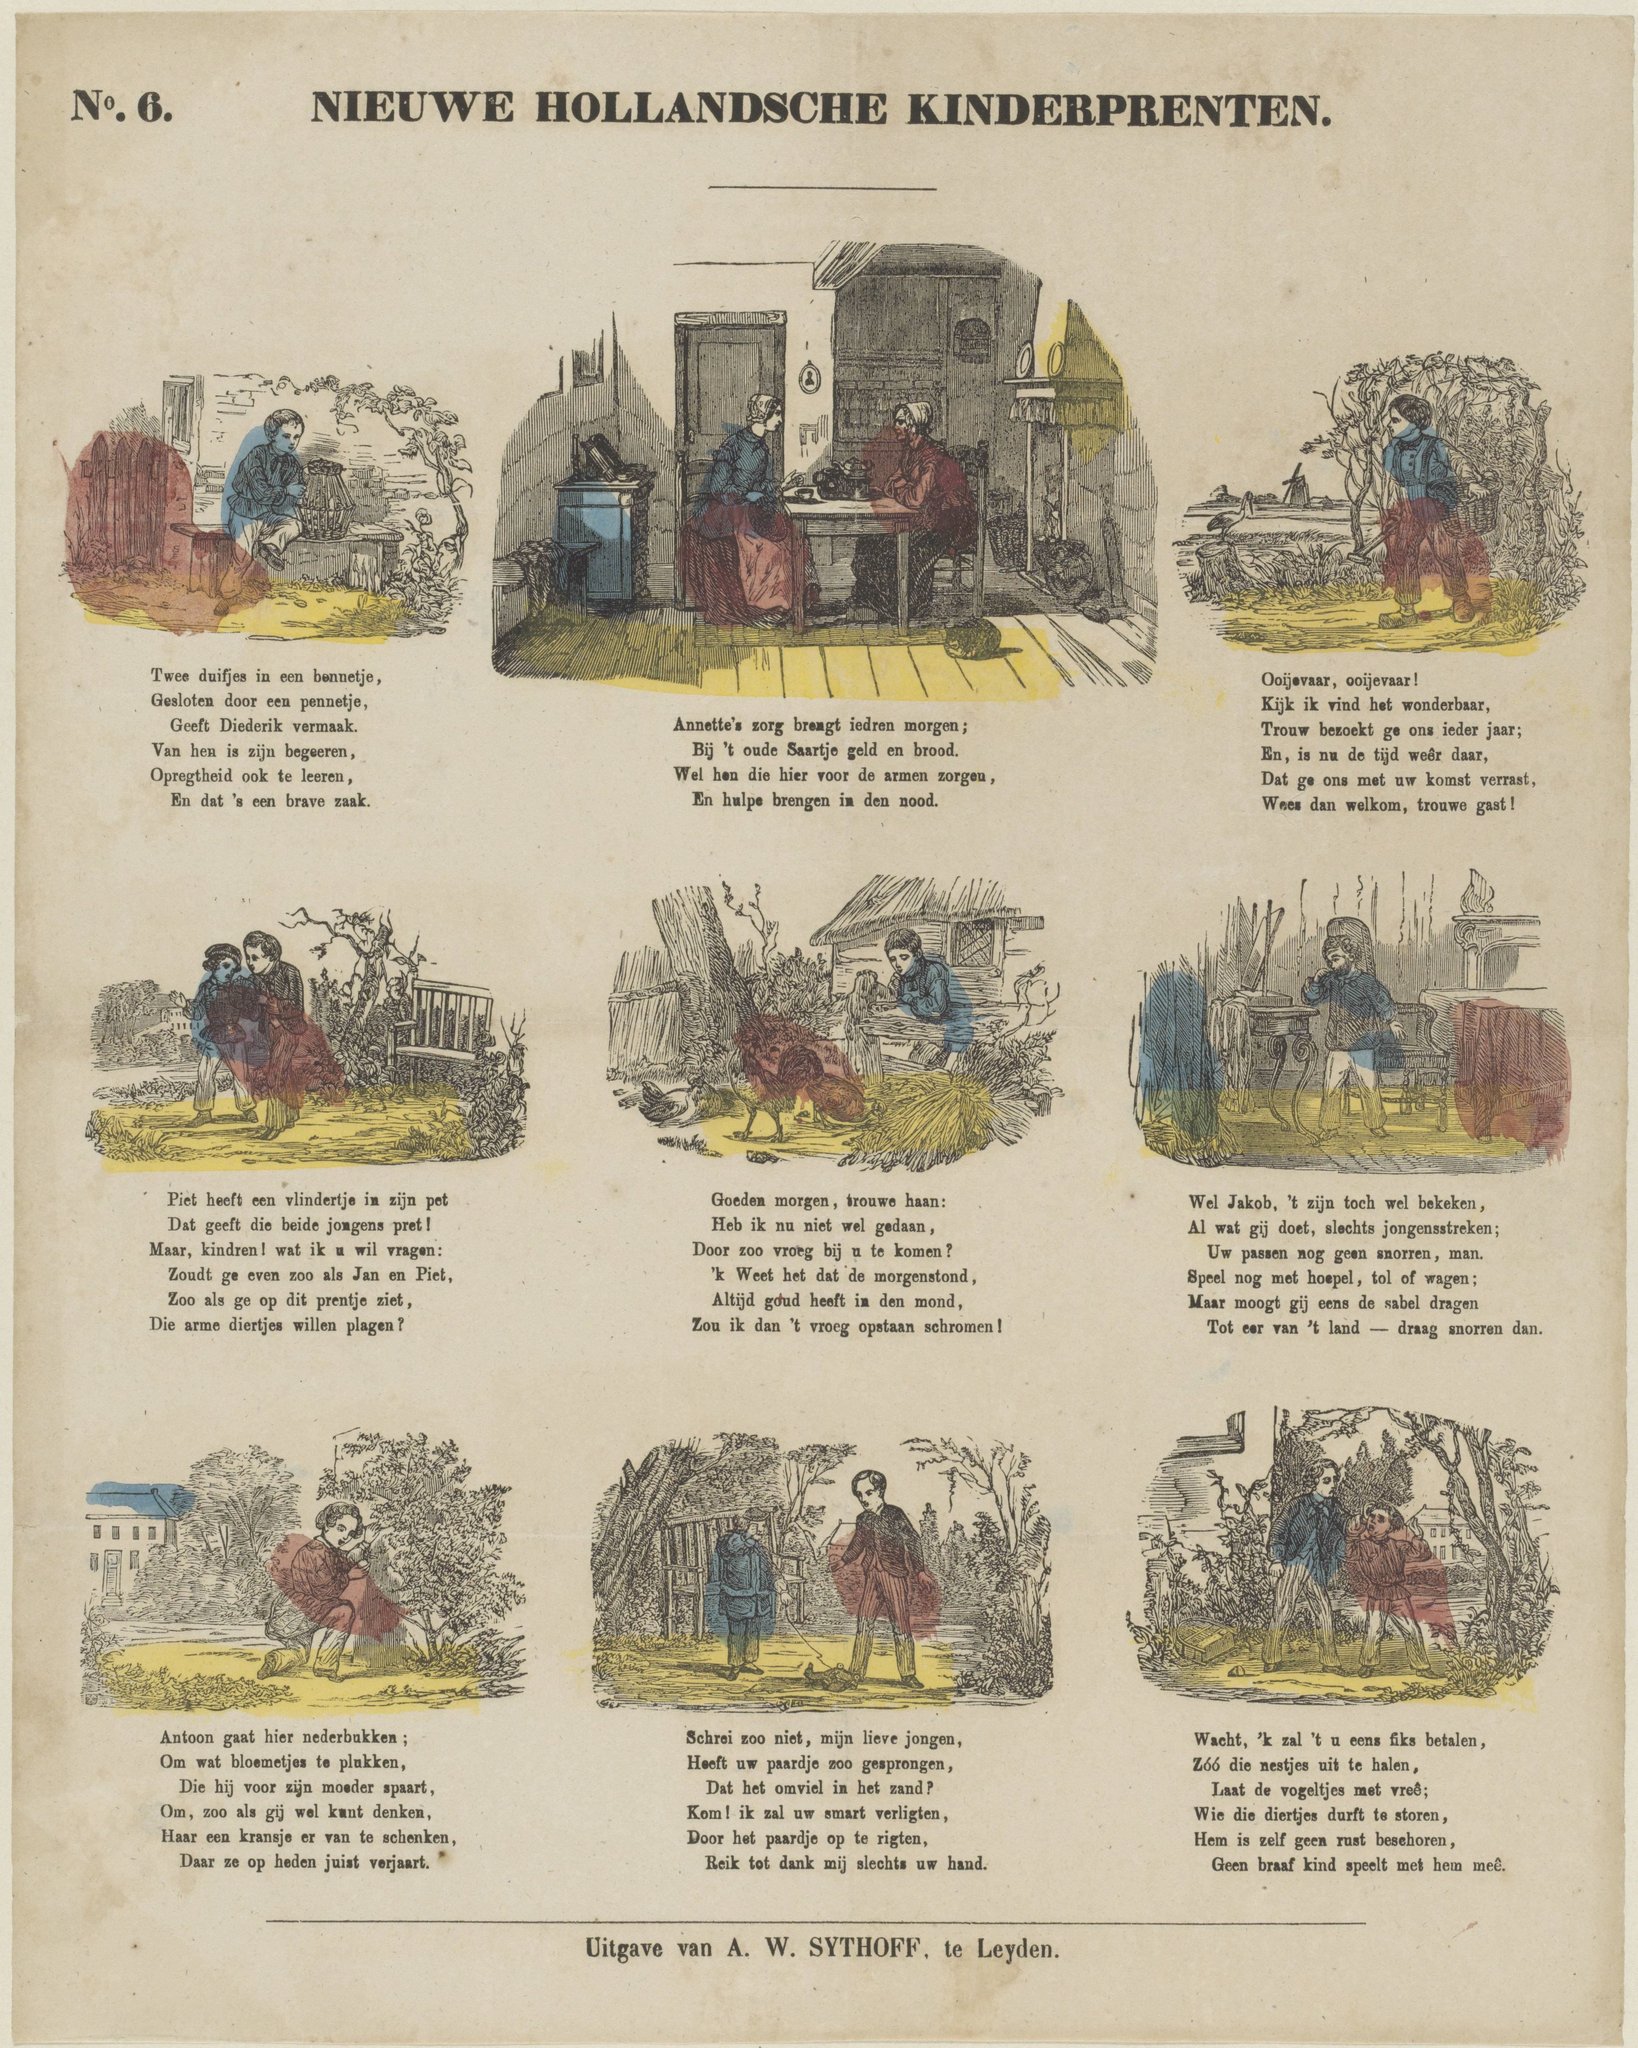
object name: print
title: Twee duifjes in een bennetje [(...)]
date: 1861-1929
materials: paper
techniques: colour, letterpress printing, engraving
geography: europe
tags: children's games and plays, human types, child, characters (human types), child playing with animals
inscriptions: collector's mark: Lugt 2760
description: Blad met 9 voorstellingen van verschillende aard, zoals voorstellingen van een jongen met duifjes in een kooitje, van twee vrouwen aan een keukentafel en van twee jongens die een vlinder hebben gevangen. Onder elke voorstelling een vier- of zesregelig vers. Genummerd linksboven: No. 6.